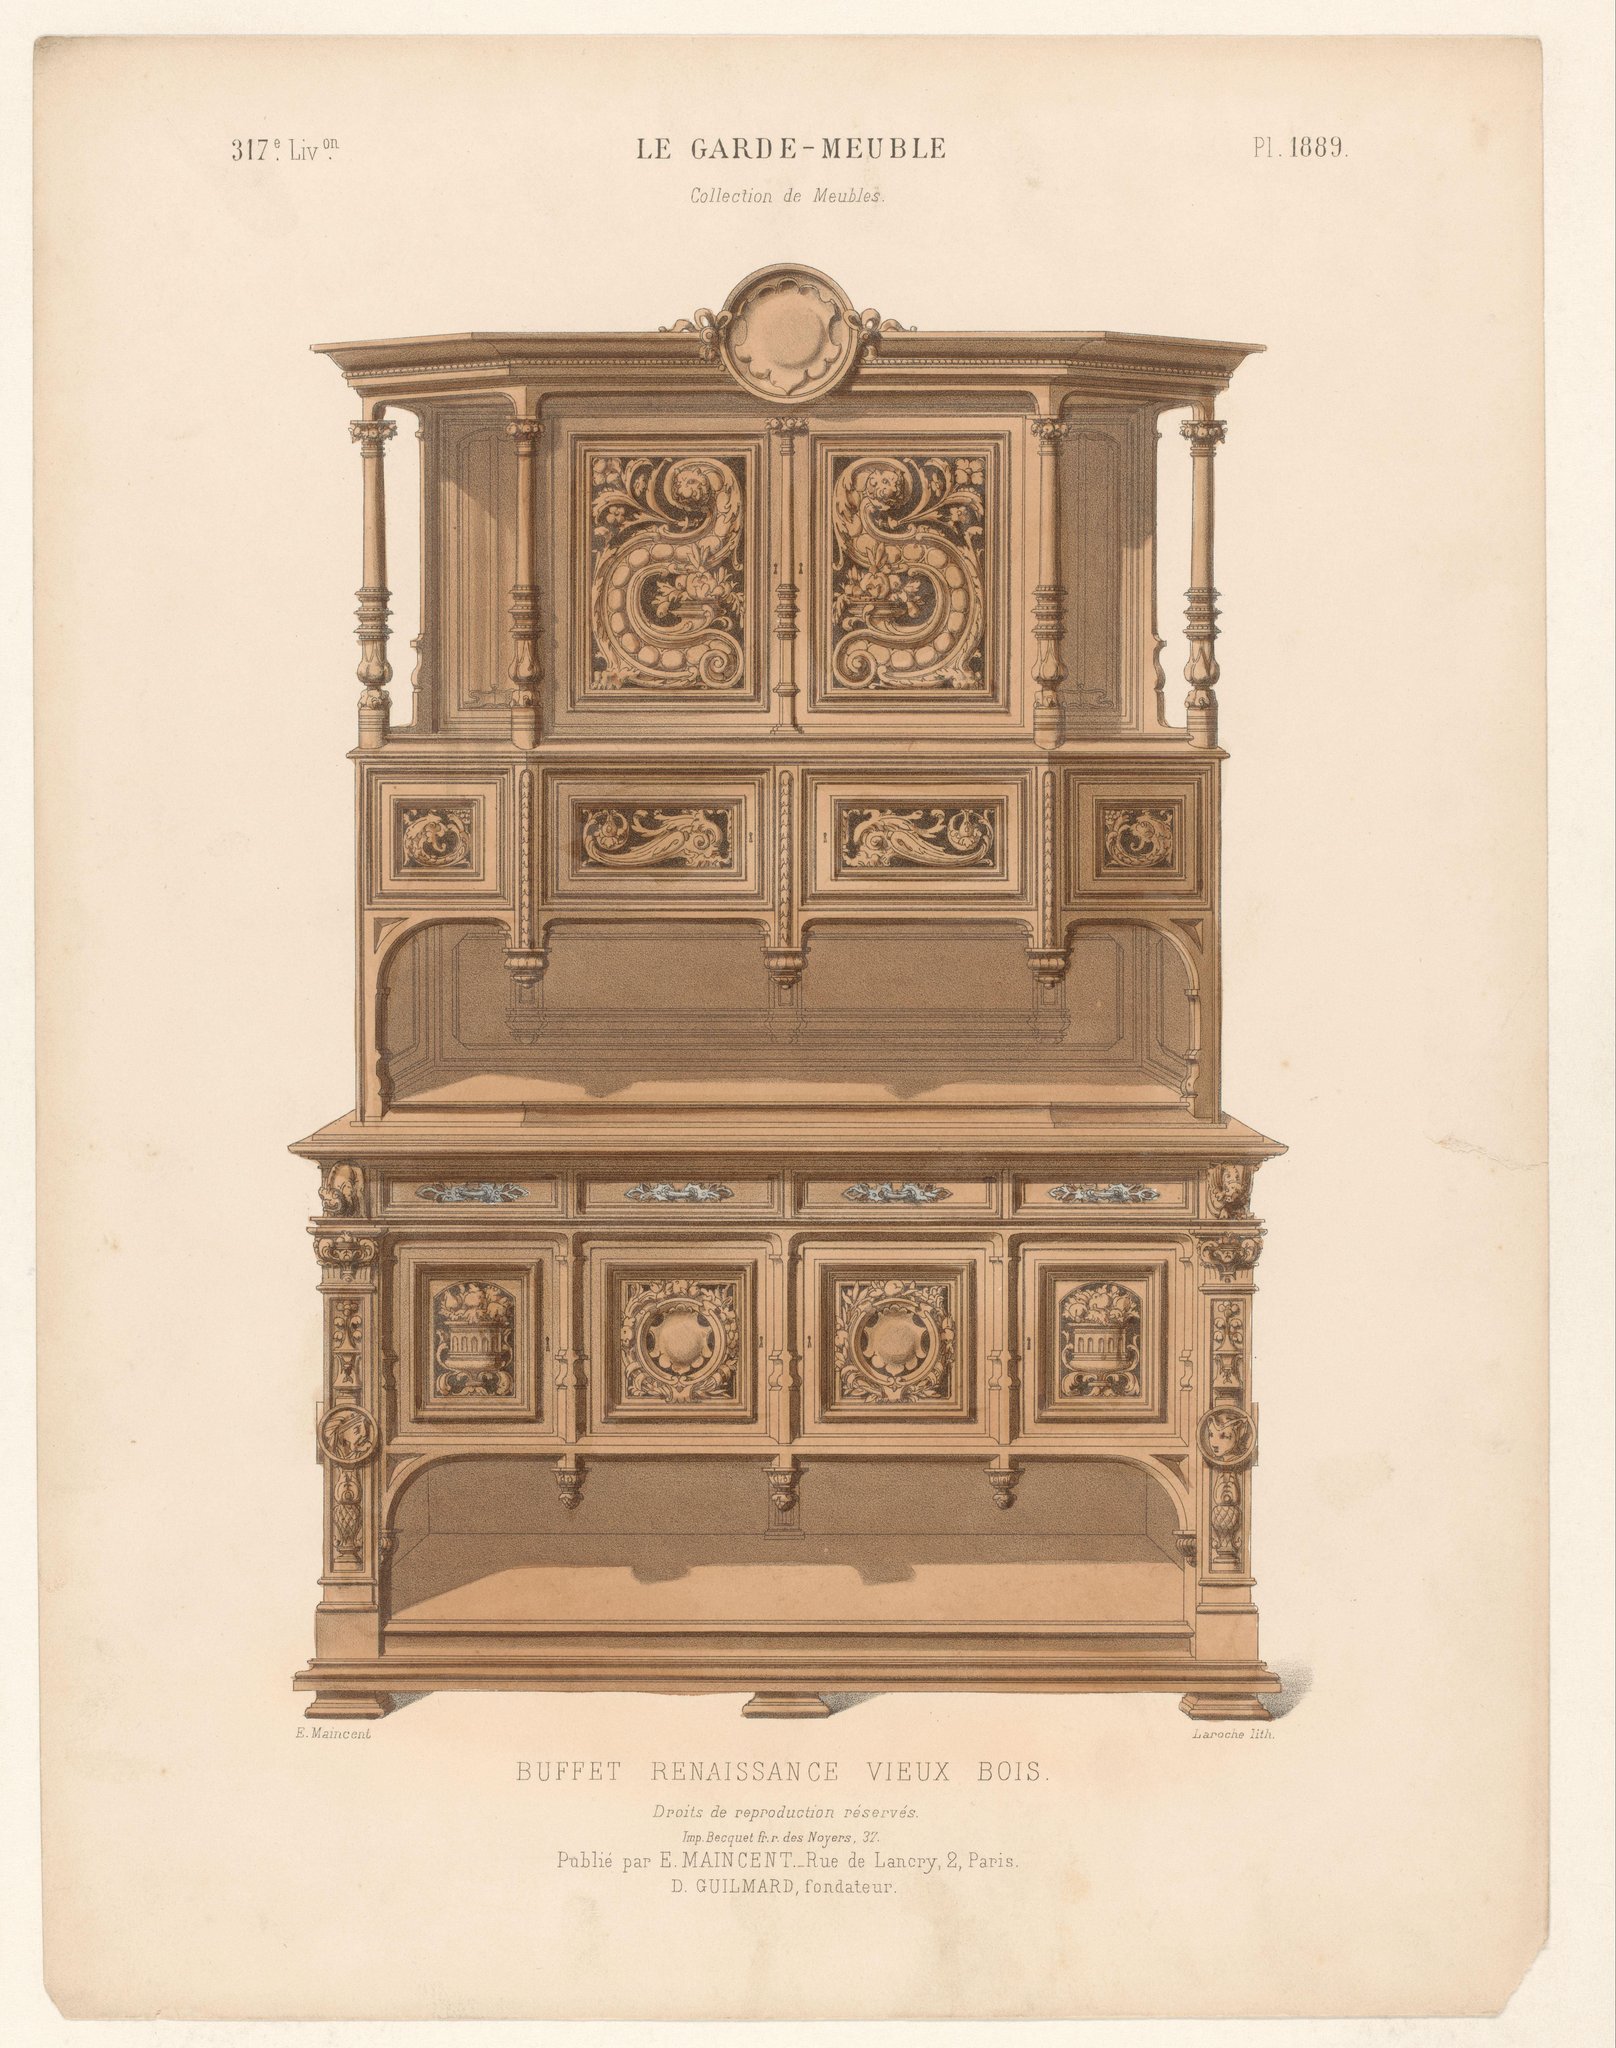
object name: print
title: Le garde-meuble / Collection de Meubles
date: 1885-1895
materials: paper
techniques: hand coloring, lithograph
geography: paris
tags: furniture for storage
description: Ieder Livraison in de serie Le Garde-Meuble bevat negen platen: drie 'sièges' (zitmeubels), drie 'meubles' (diverse meubels zoals tafels en kasten) en drie 'tentures' (gordijnen en draperieën).